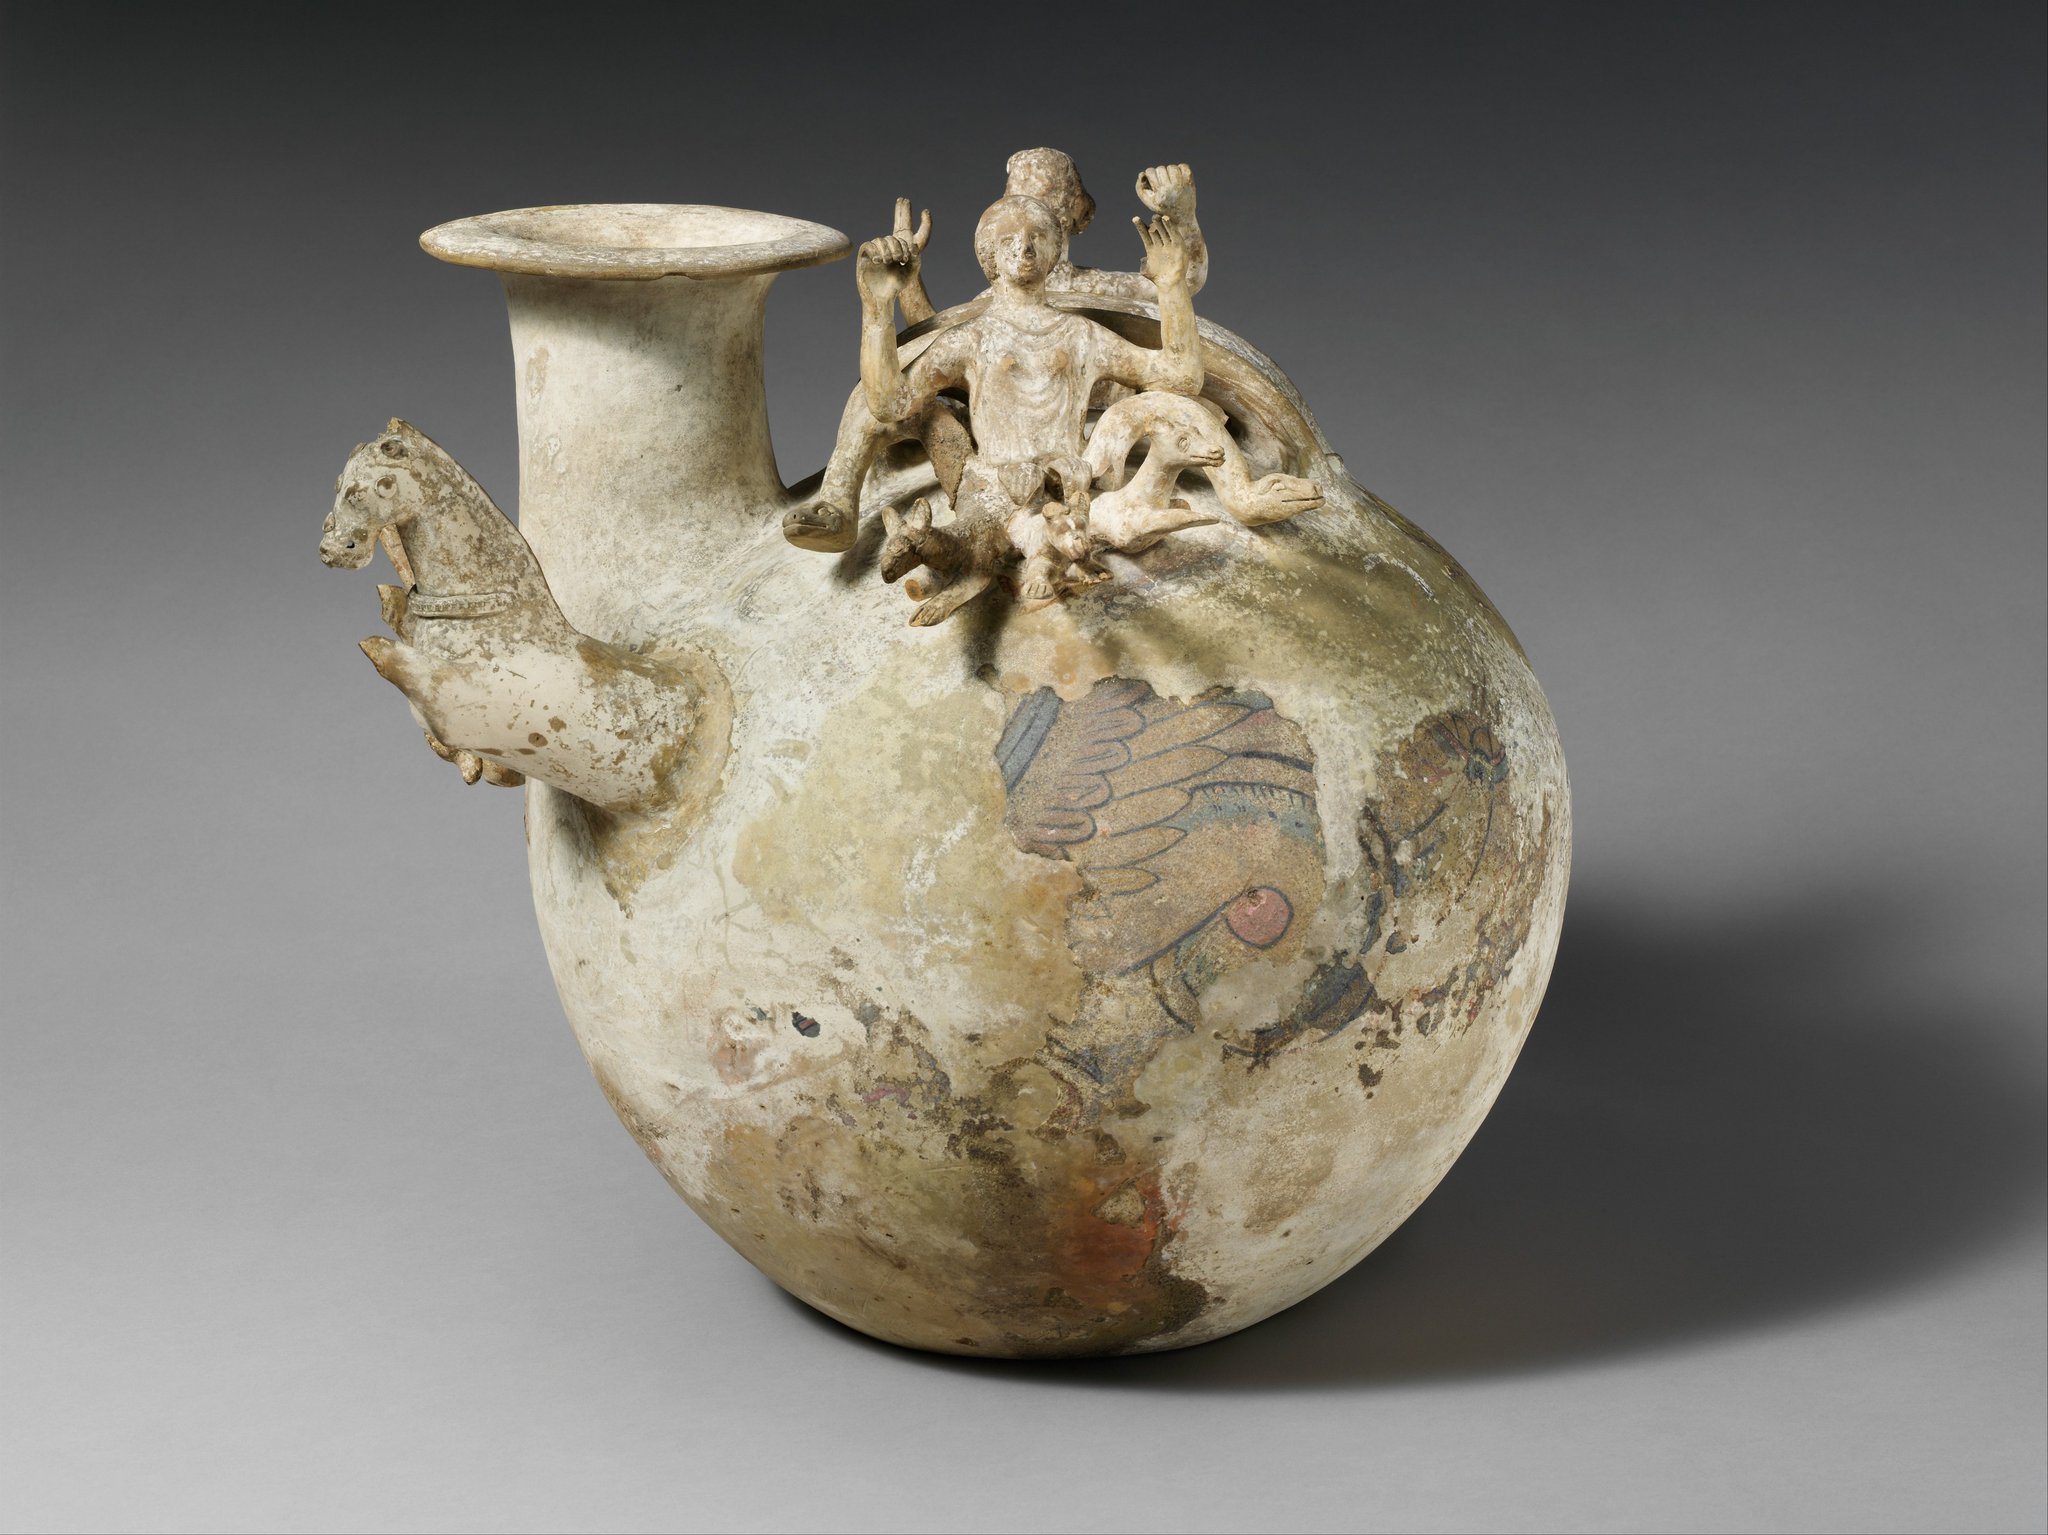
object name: askos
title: Terracotta askos (flask with a handle over the top)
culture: greek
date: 300-201 BCE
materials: terracotta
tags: horses,scylla